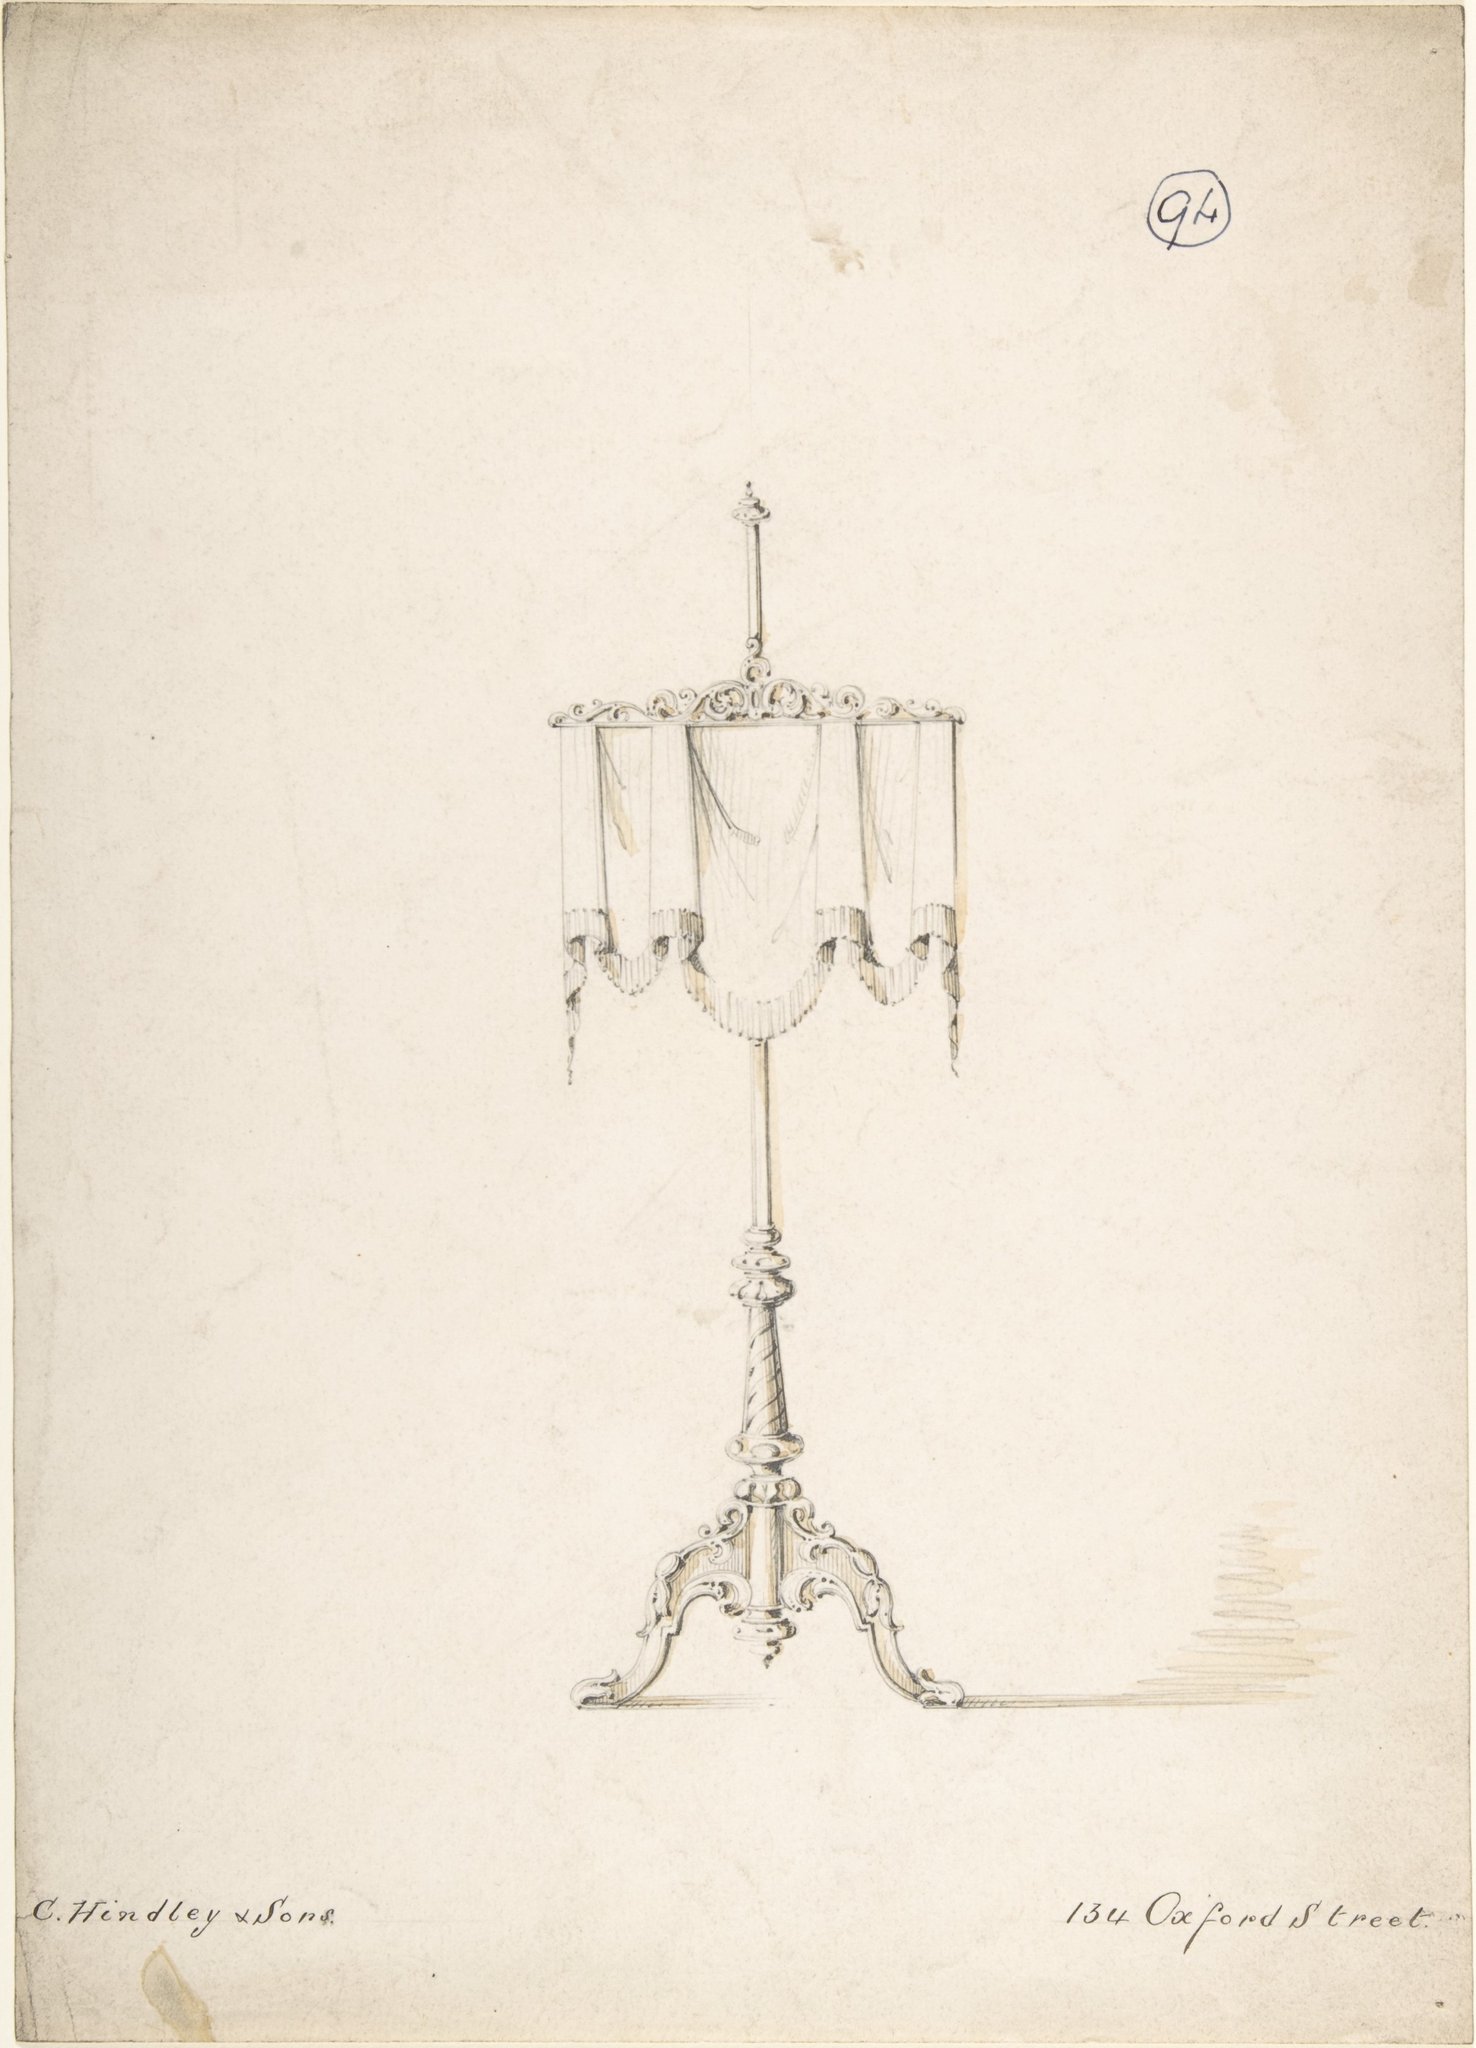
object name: drawing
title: Design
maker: charles hindley and sons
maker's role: artist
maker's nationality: british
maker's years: 1841-1917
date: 1841-1884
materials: graphite, ink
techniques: brush, pen, wash